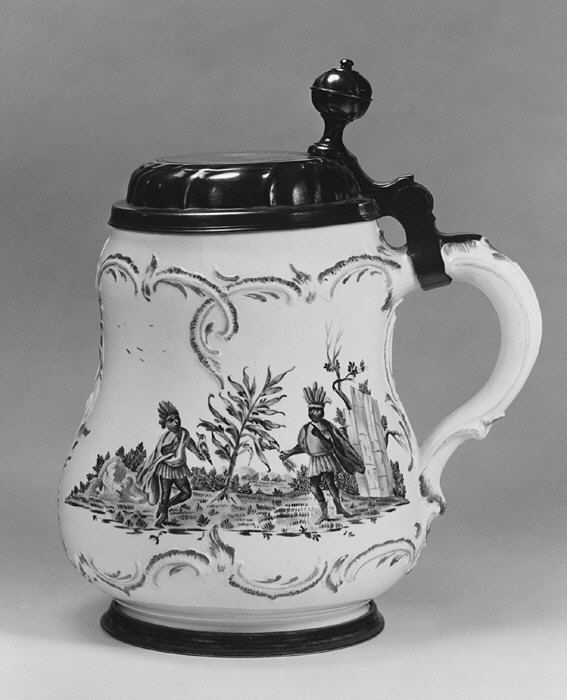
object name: tankard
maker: nymphenburg porcelain manufactory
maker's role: manufactory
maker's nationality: german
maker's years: 1747-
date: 1778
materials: hard paste porcelain, pewter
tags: men,plants